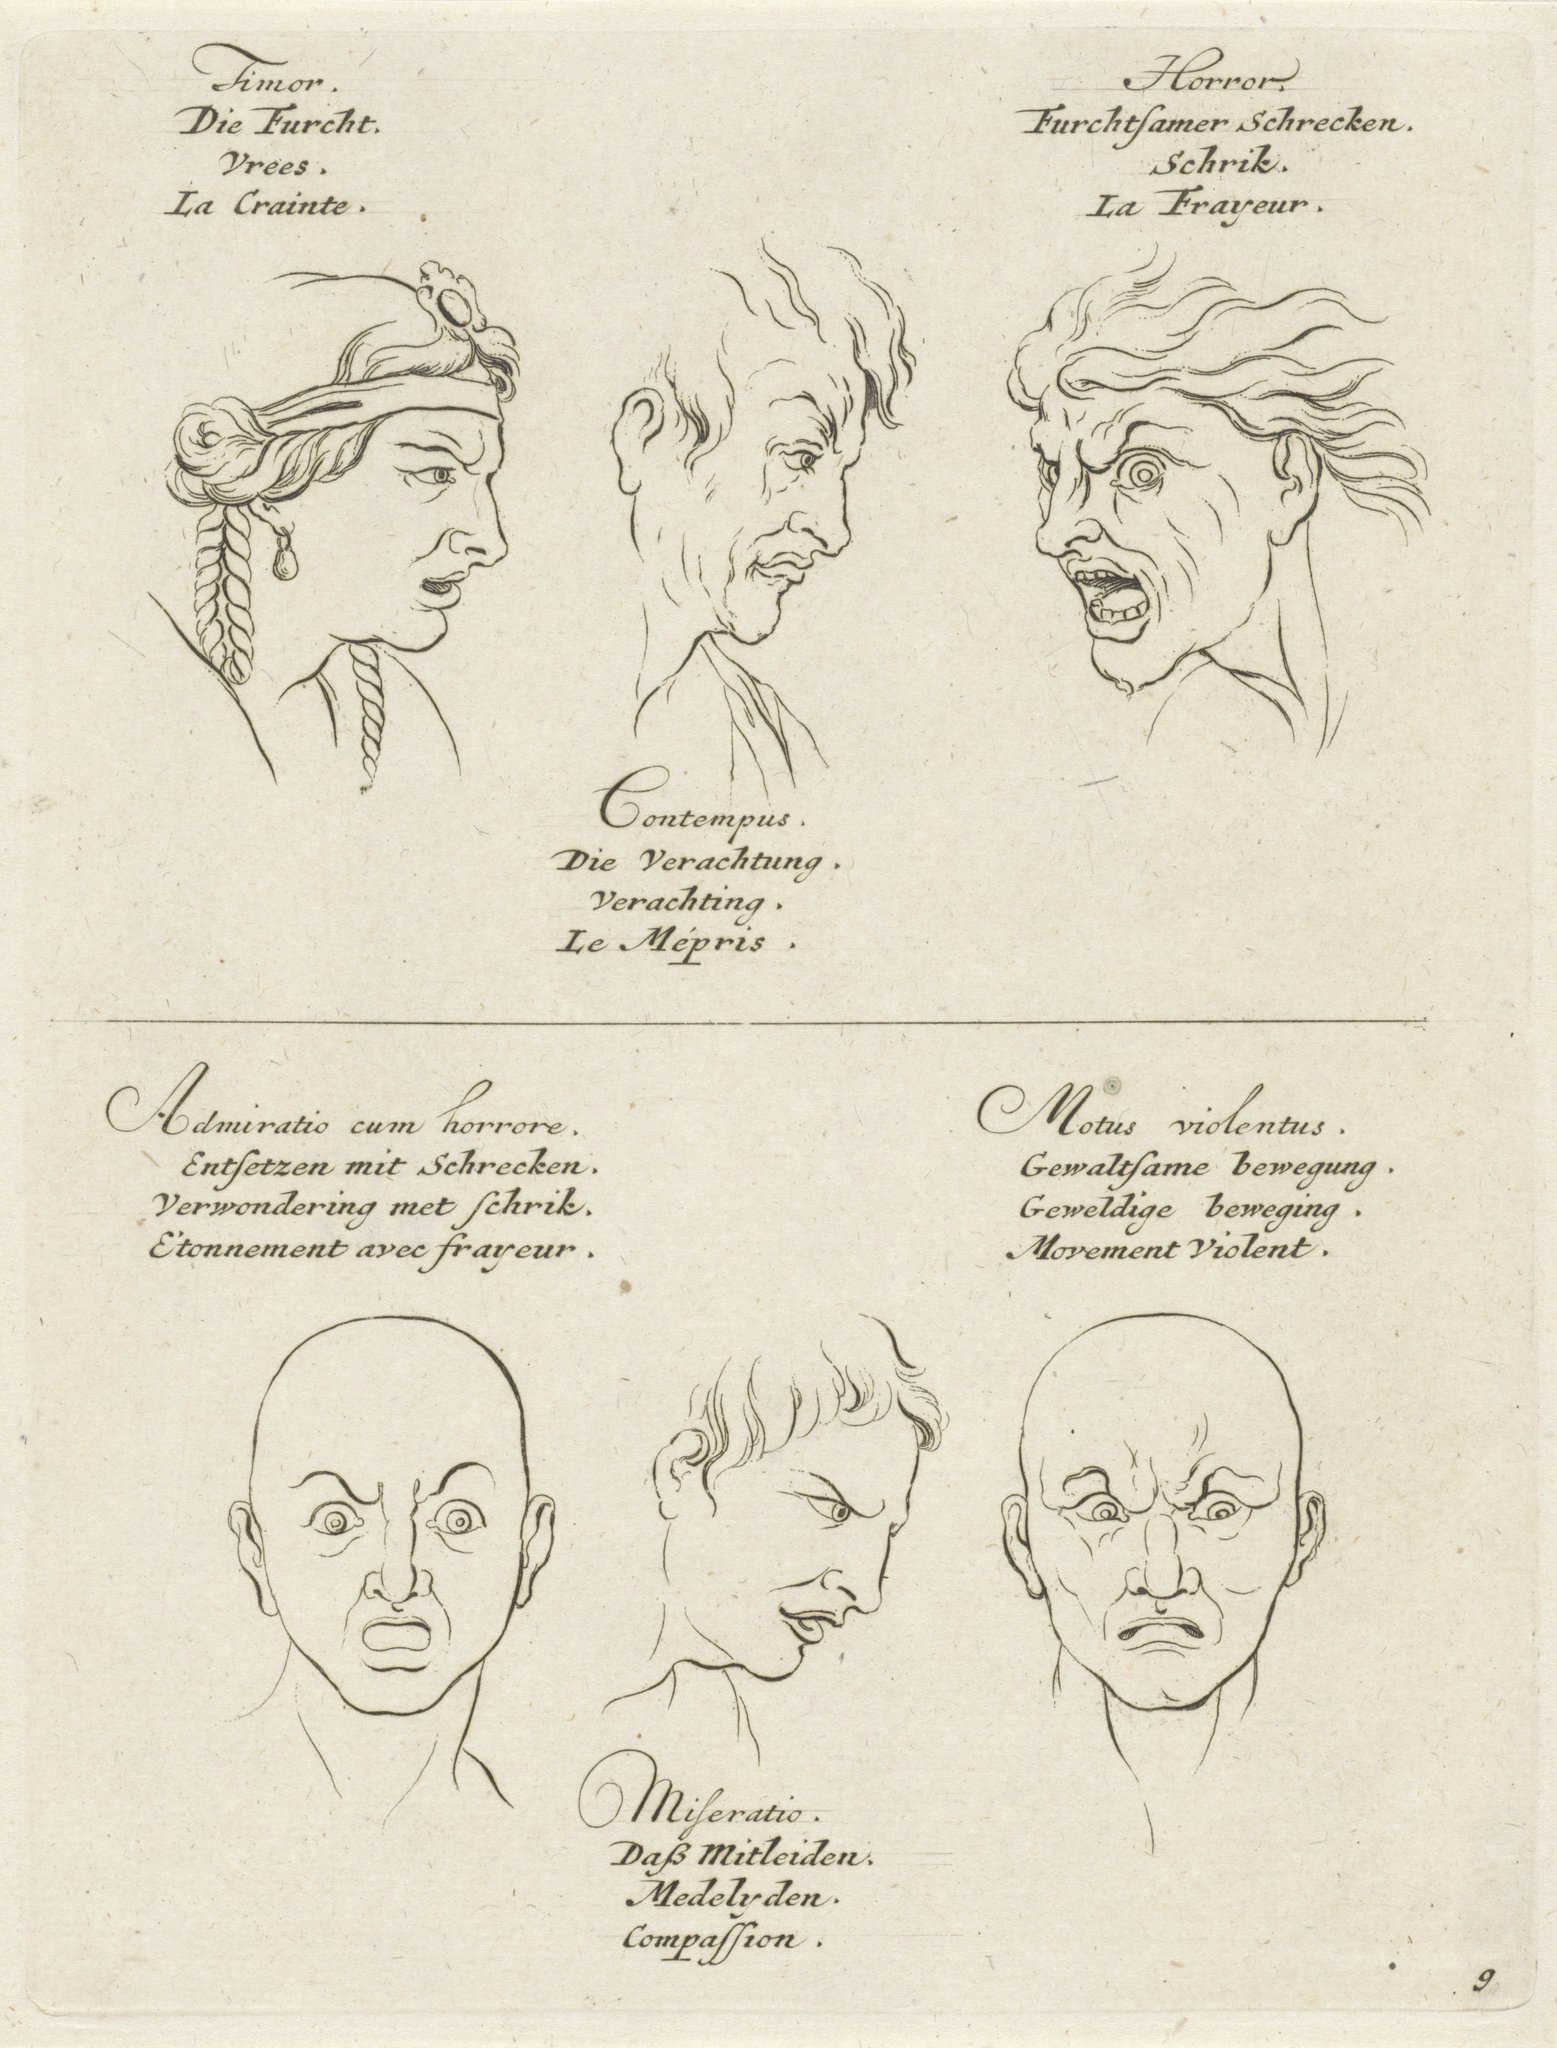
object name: print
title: Aftekening en verbeelding der hartstogten / Abbild oder Vorstellung der Gemühts regungen/ Effigies et Repraesentatio Affectionum animi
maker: pieter schenk (i)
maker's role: print maker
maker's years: 1660-1711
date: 1692-1711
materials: paper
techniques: etching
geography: amsterdam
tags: morphology of facial expression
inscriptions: collector's mark: Lugt 2233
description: Bovenaan drie gezichten met gezichtsuitdrukkingen van vrees, verachting en schrik. Onderaan drie gezichten met gezichtsuitdrukkingen van verwondering met schrik, medelijden en geweldige beweging.